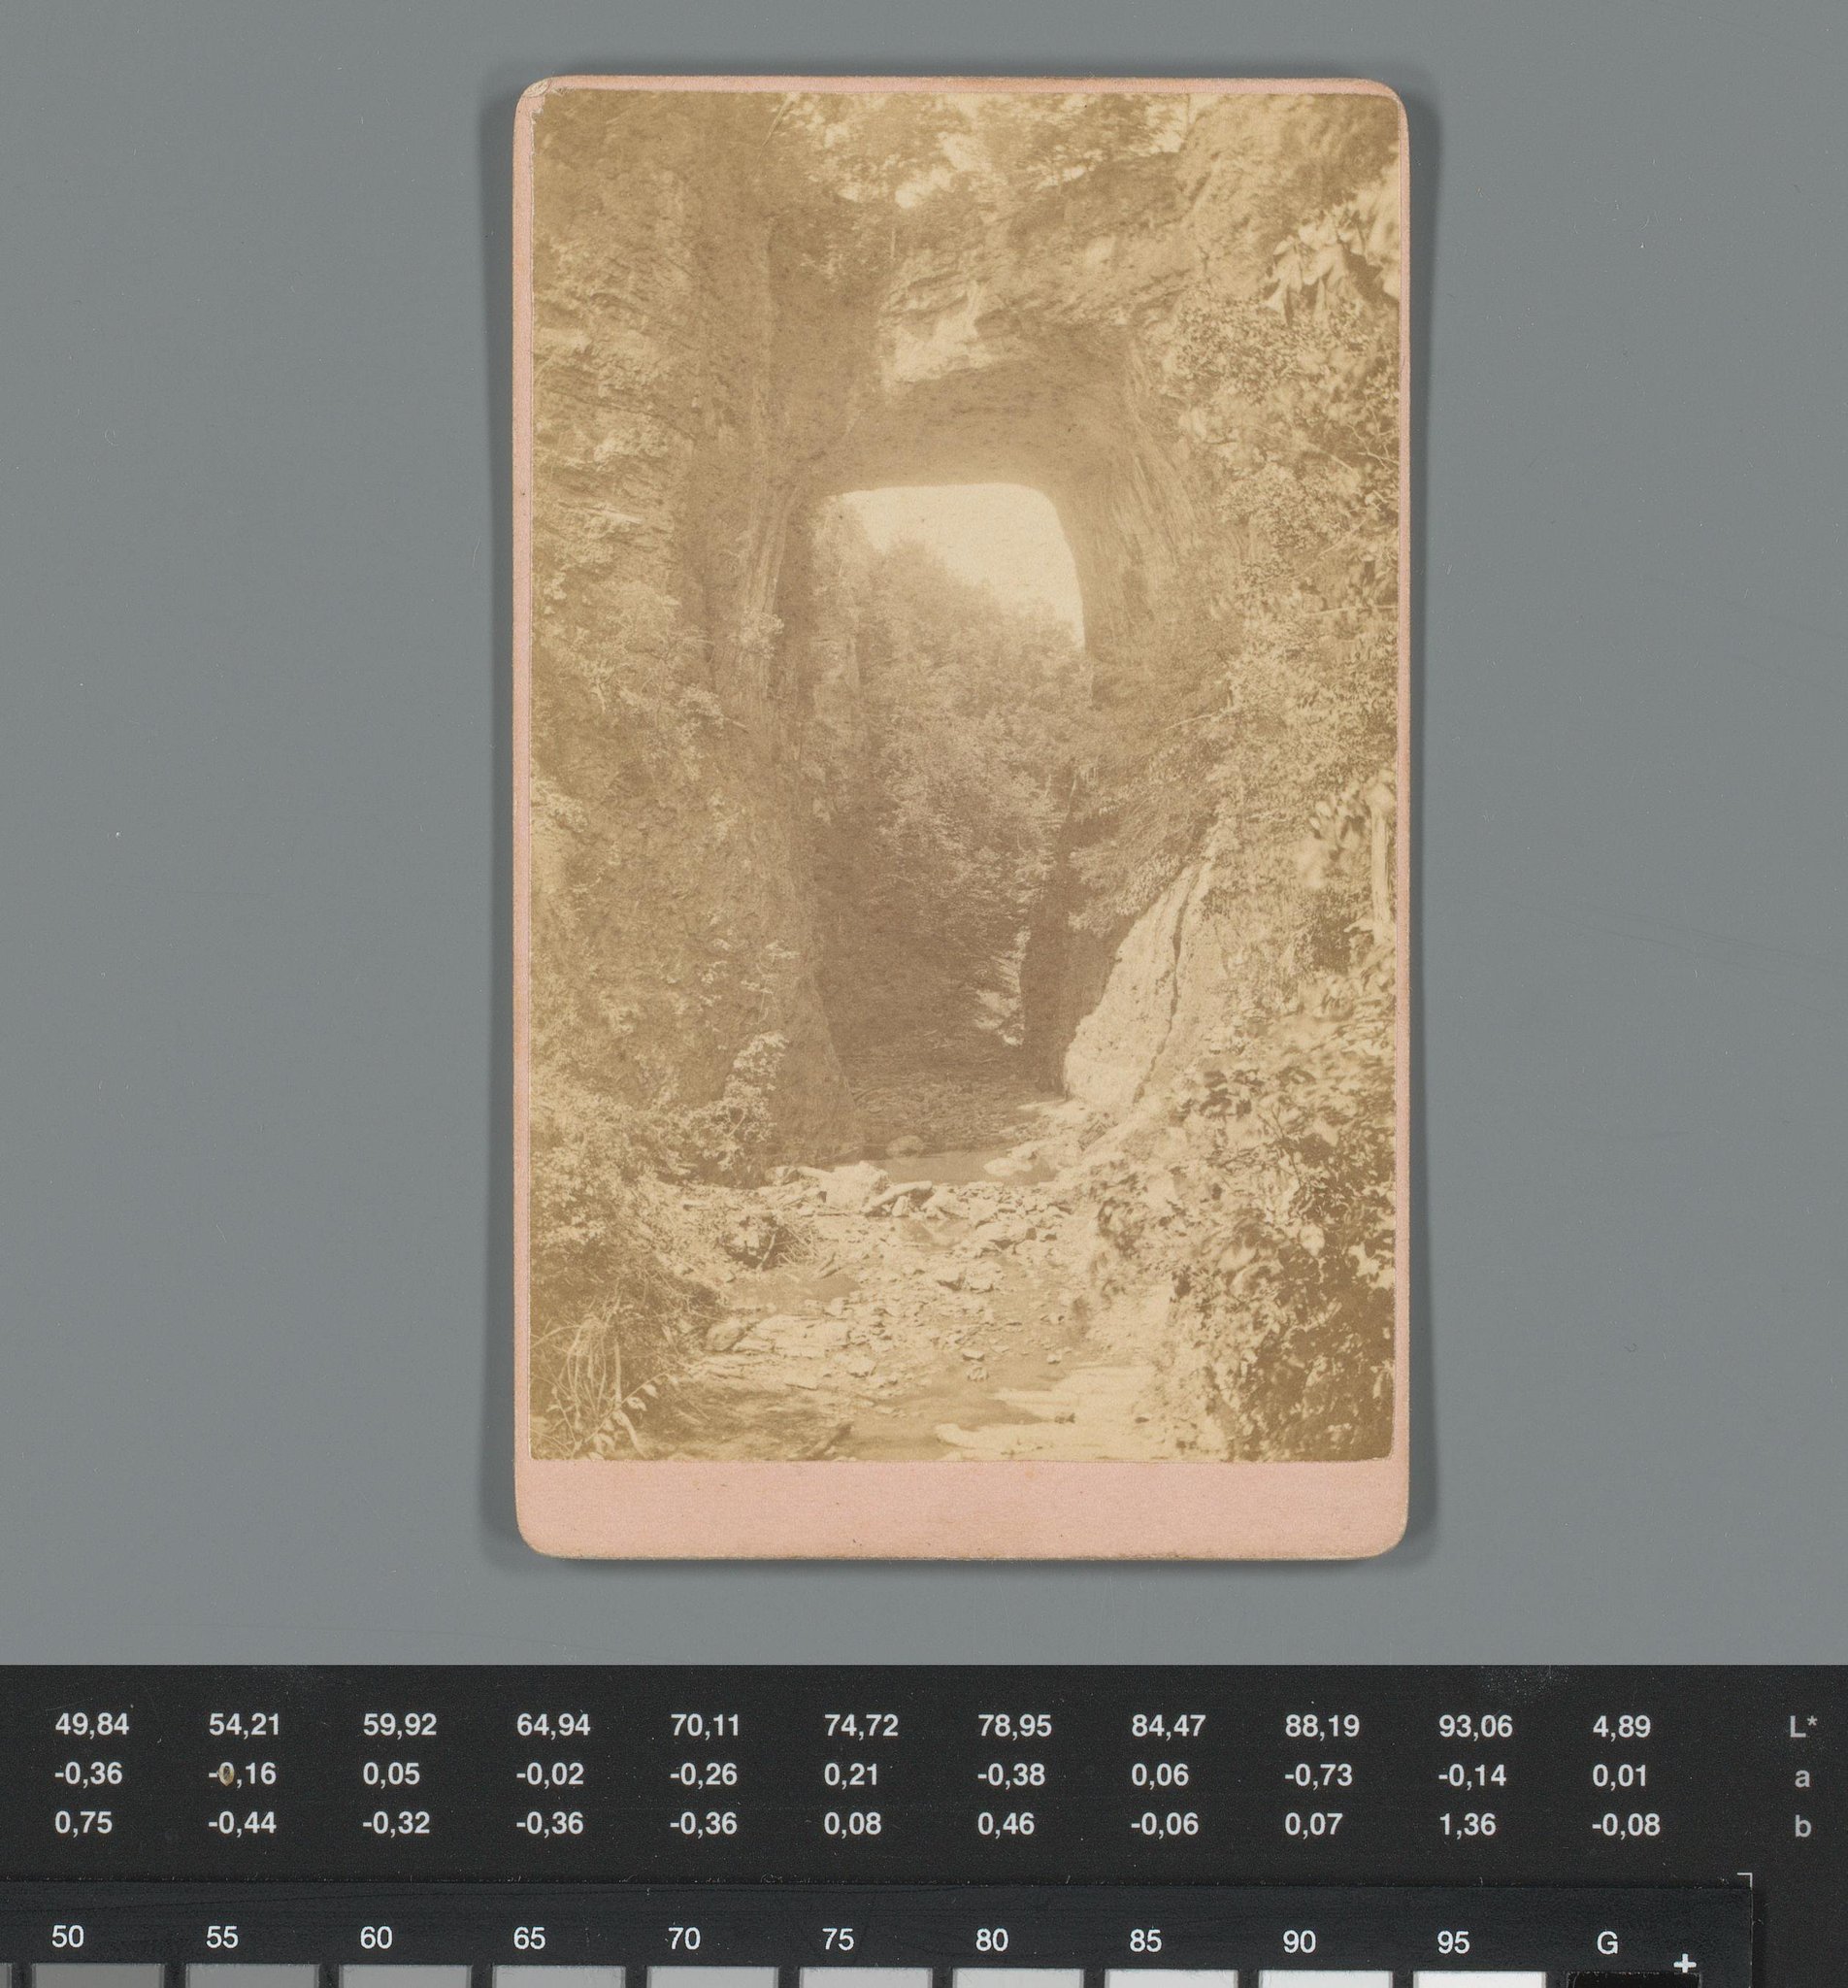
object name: photograph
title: Gezicht op 'Natural Bridge' in Rockbridge County, Virginia, met reclame voor een hotel nabij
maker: Anonymous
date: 1850-1915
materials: cardboard, photographic support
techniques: albumen print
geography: virginia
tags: advertising, rock-formations, hotel, hostelry, inn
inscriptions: inscription: ‘(...)’